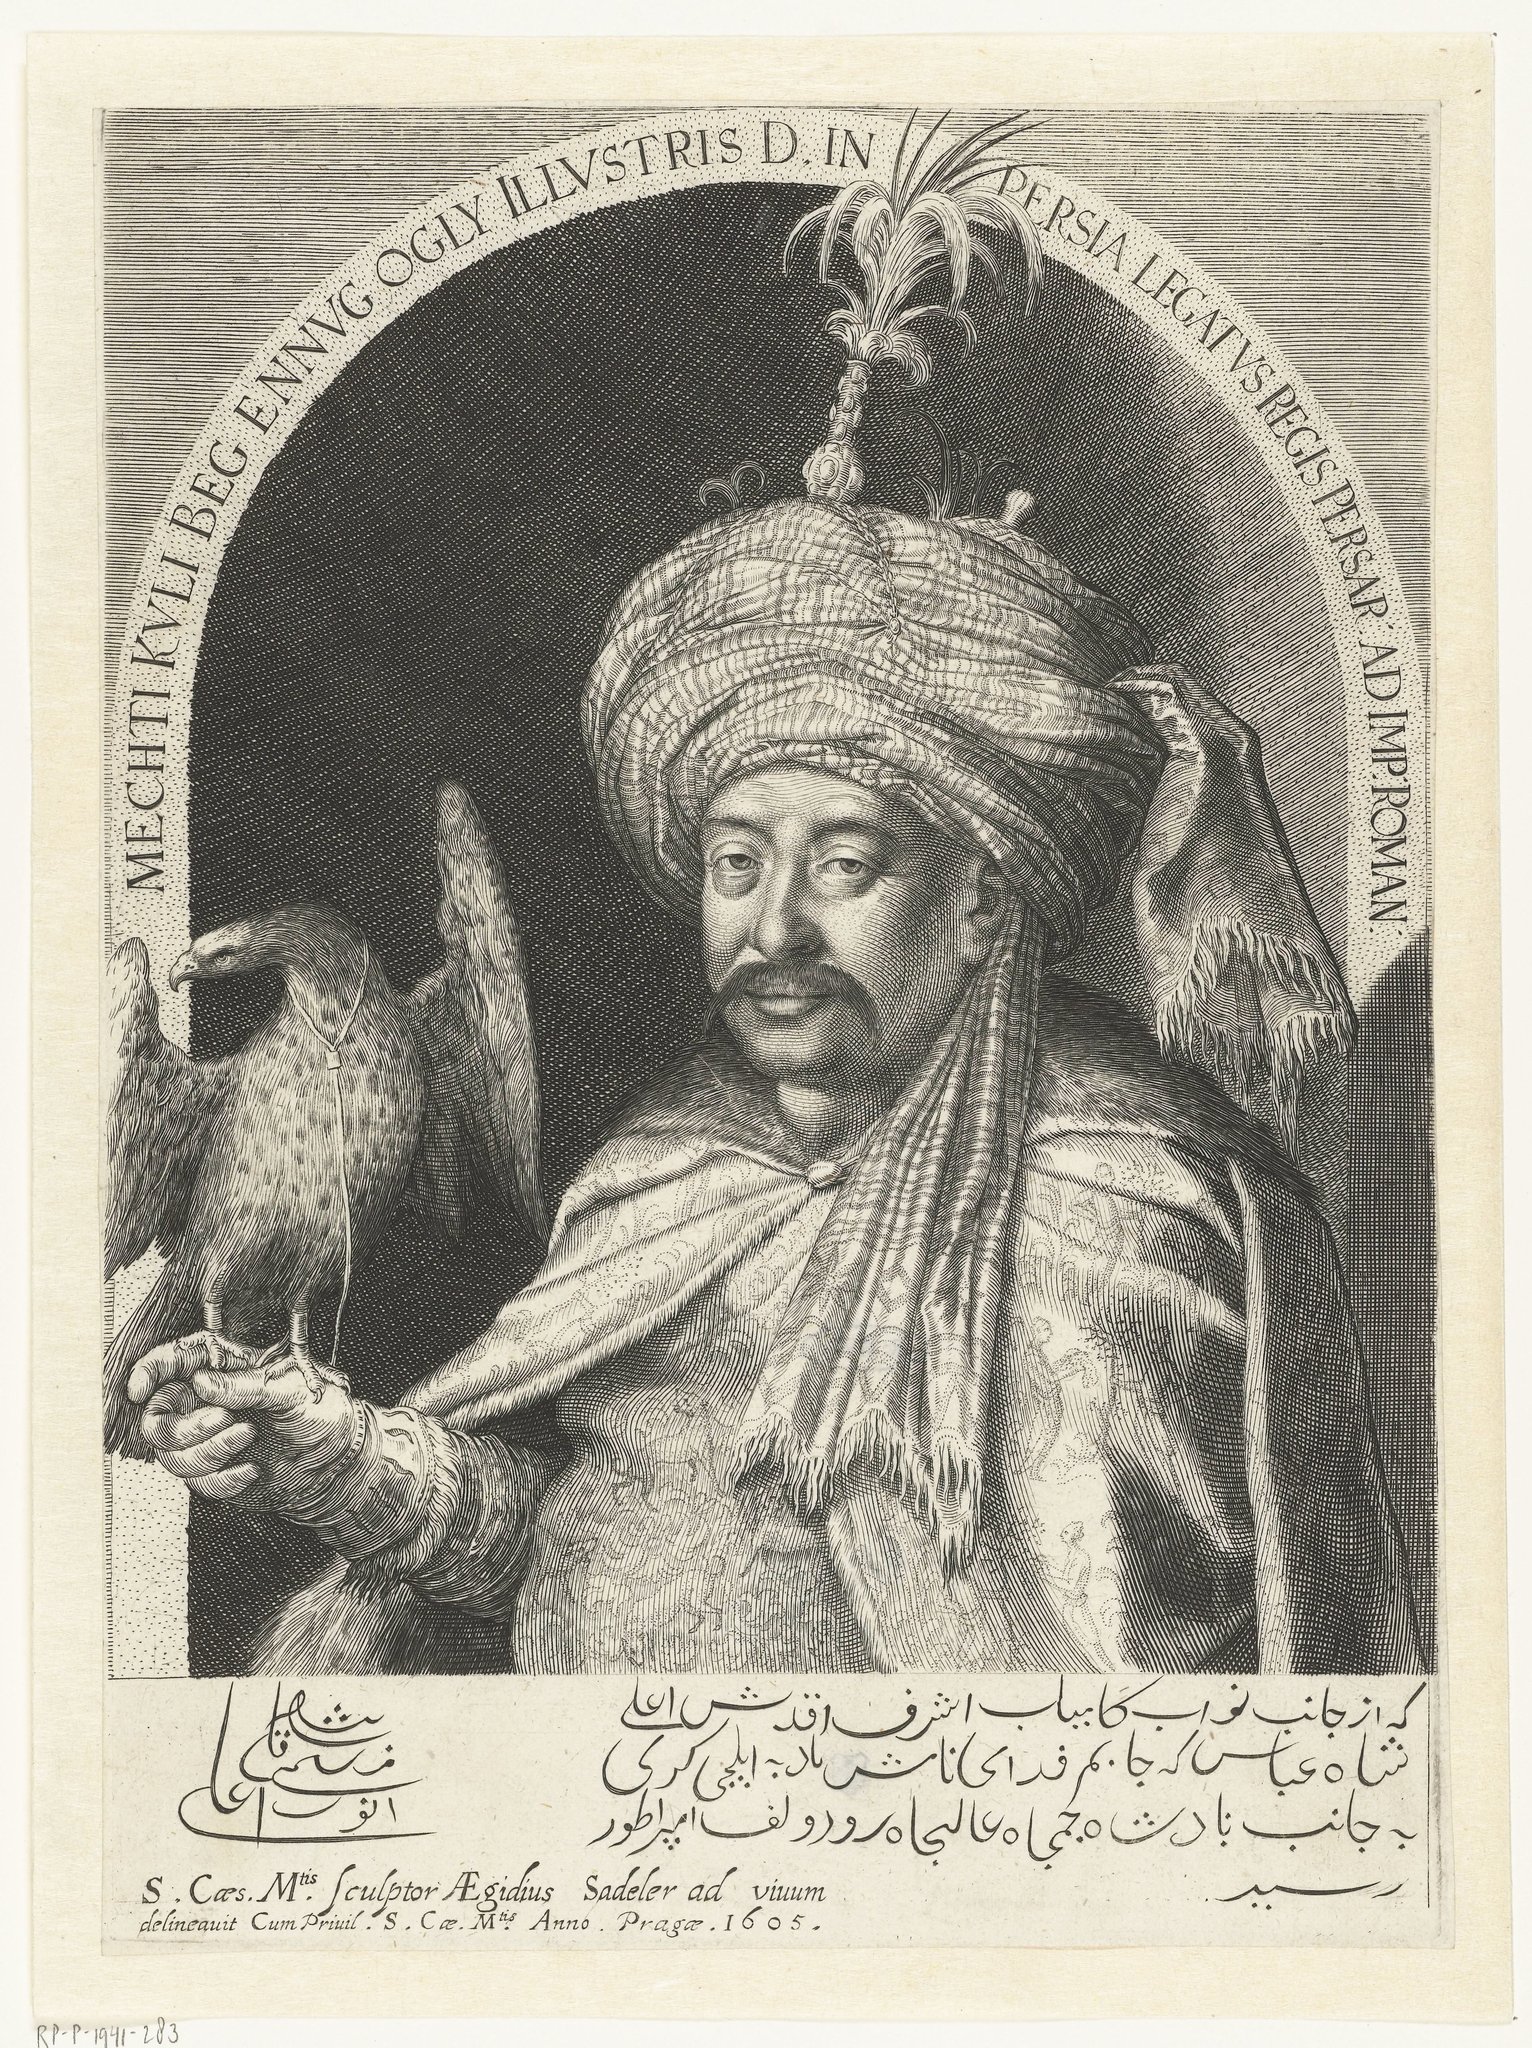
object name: print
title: Portret van Mechti Kuli Beg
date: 1605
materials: paper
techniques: engraving, etching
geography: prague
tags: predatory birds: eagle, head-gear: turban, asiatic races and peoples: persians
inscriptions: collector's mark: Lugt 2228, collector's mark: Lugt 2760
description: Mechti Kuli Beg, ambassadeur van Perzië aan het keizerlijk hof van Rudolf II in Praag. Hij draagt een tulband. Op zijn rechterhand een adelaar. De prent heeft een Arabisch onderschrift.